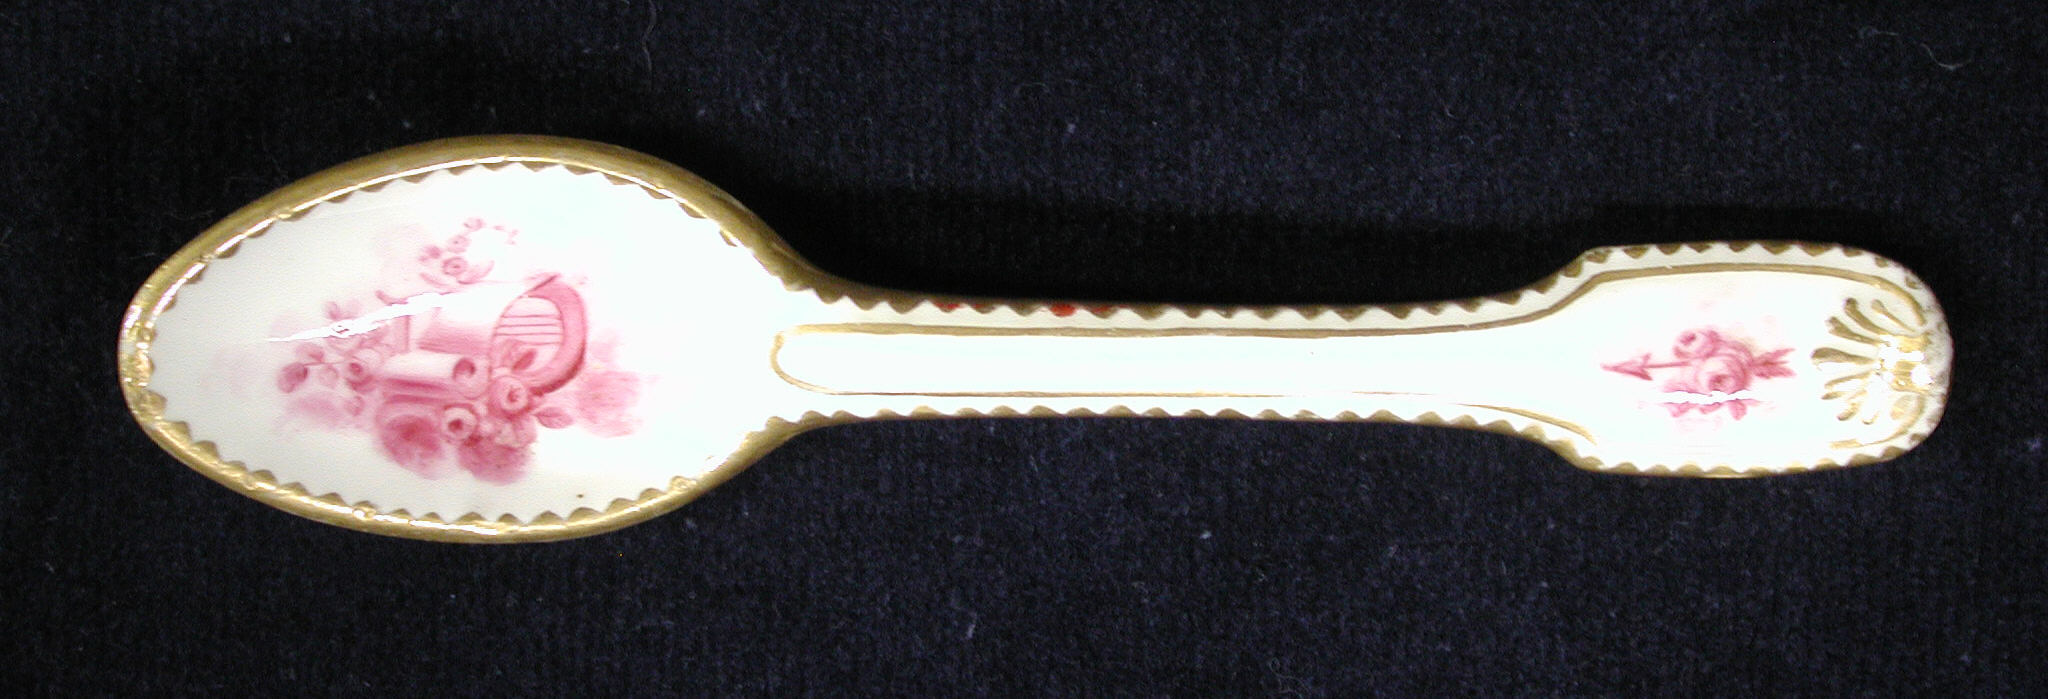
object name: teaspoon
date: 1701-1900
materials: soft paste porcelain